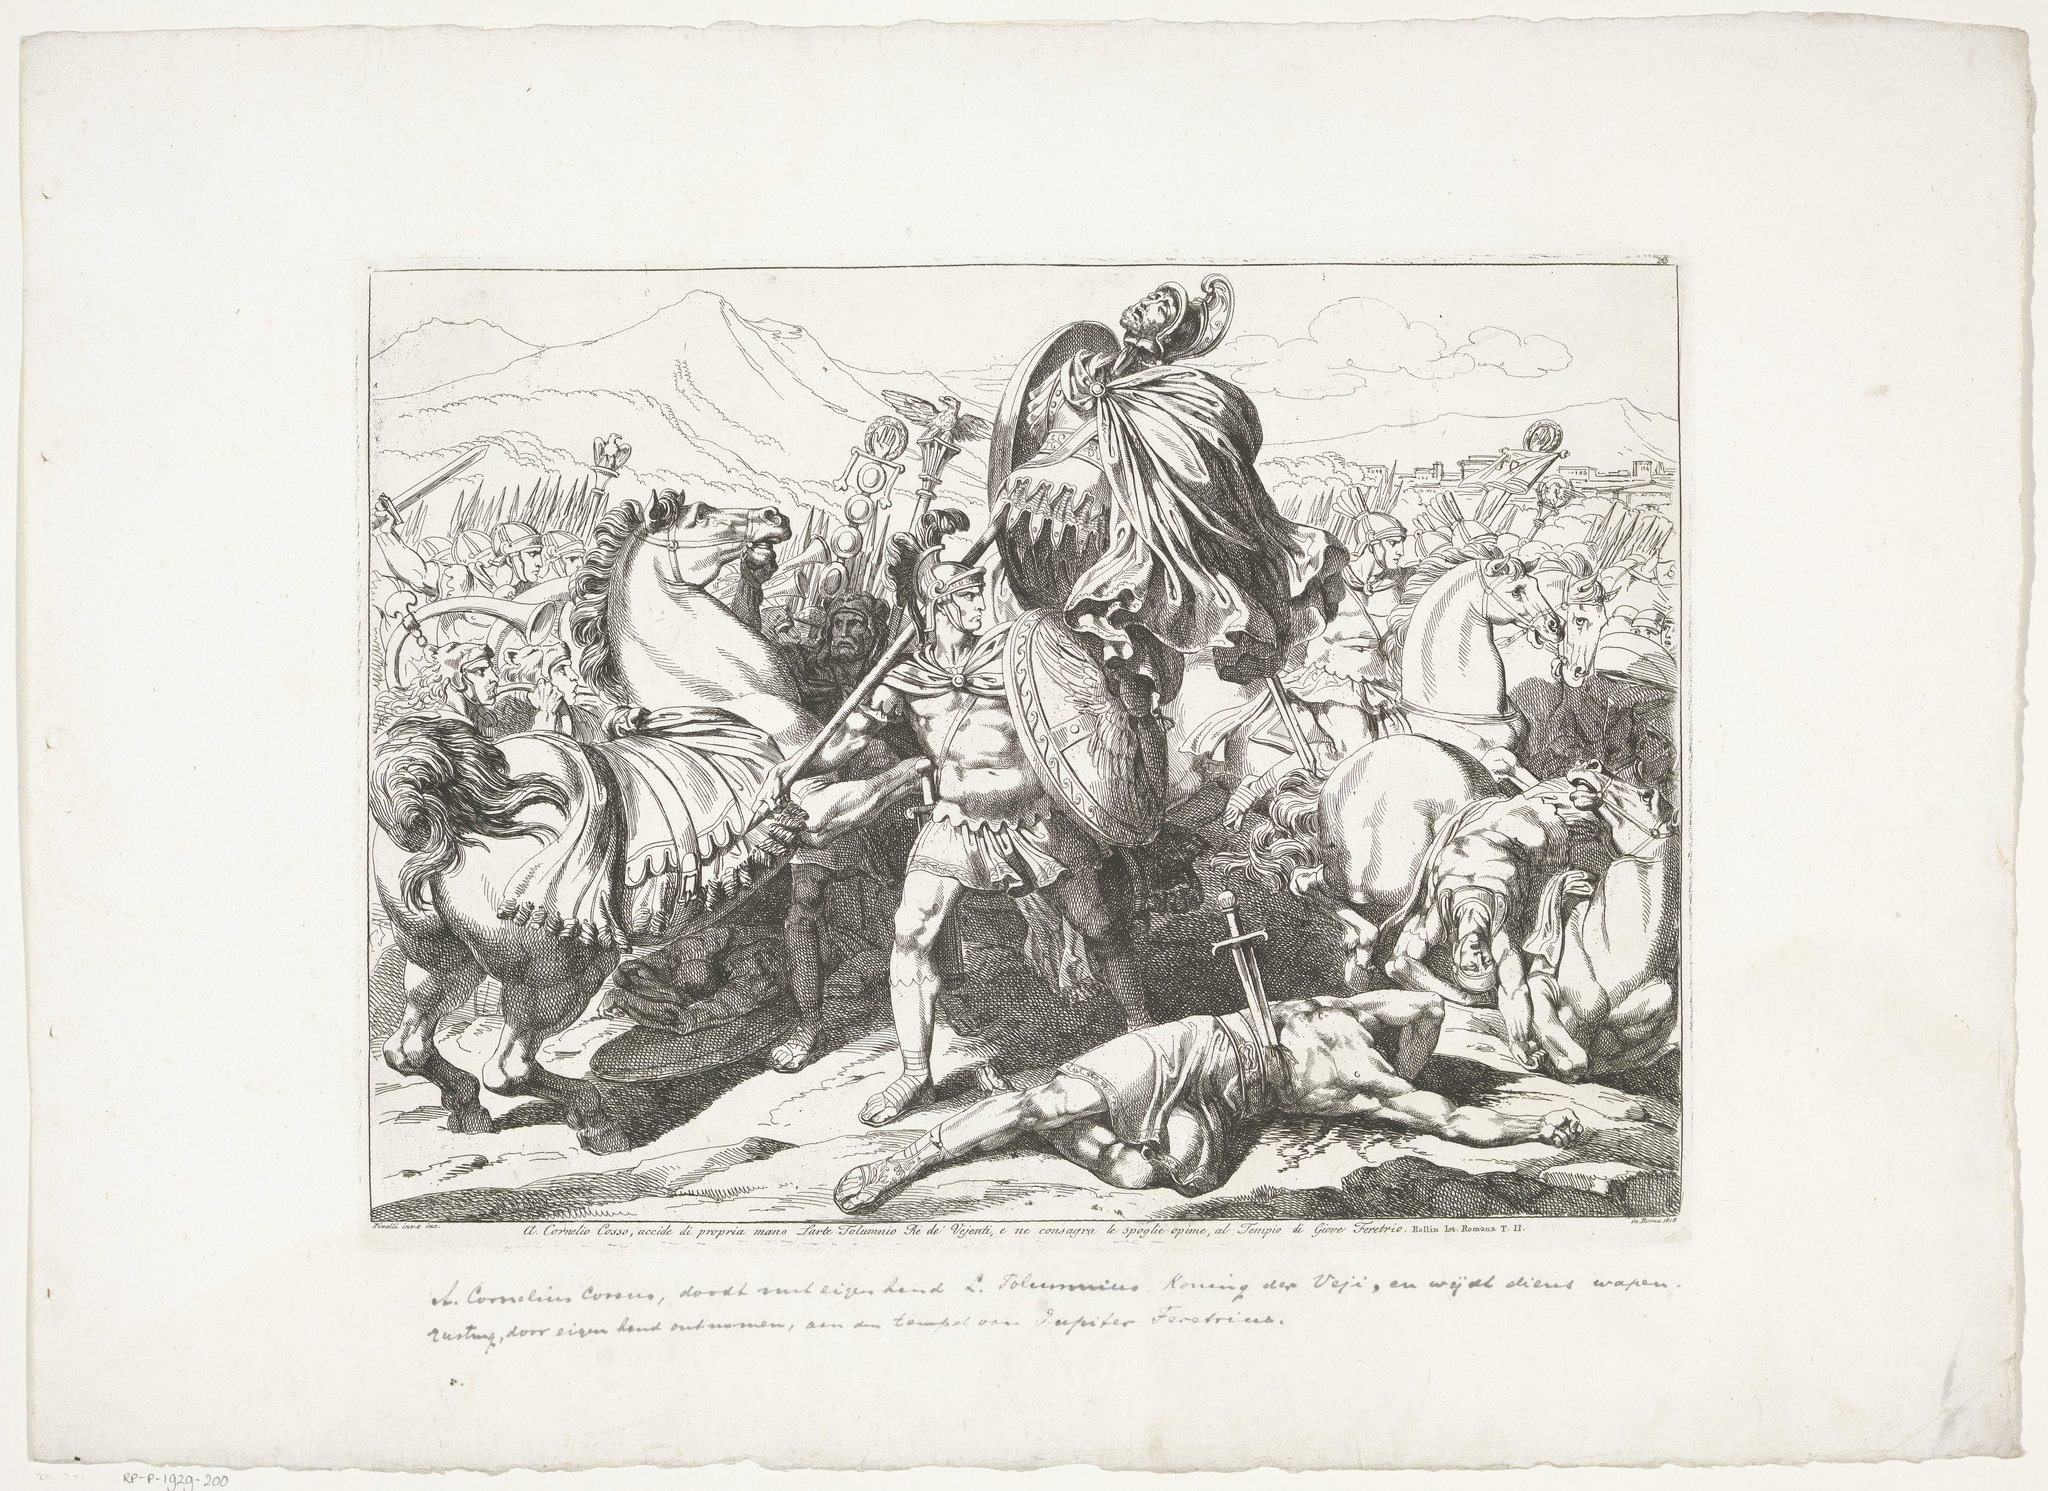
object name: print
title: Aulus Cornelius Cossus doodt Lars Tolumnius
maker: bartolomeo pinelli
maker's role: draughtsman, print maker, sculptor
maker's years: 1781-1835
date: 1818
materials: paper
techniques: etching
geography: rome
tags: violent death by sword, the soldier; the soldier's life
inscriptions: collector's mark: Lugt 2228, inscription: ‘A. Cornelius Cossus, doodt met eigen hand L. Tolumnius, Koning der Veji, en wijdt diens wapen- / rusting, door eigen hand ontnomen, aan den tempel van Jupiter Feretrius.’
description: Aulus Cornelius Cossus heeft Lars Tolumnius gedoodt met een zwaard. Hij staat triomfantelijk met diens wapenrusting op het slagveld.